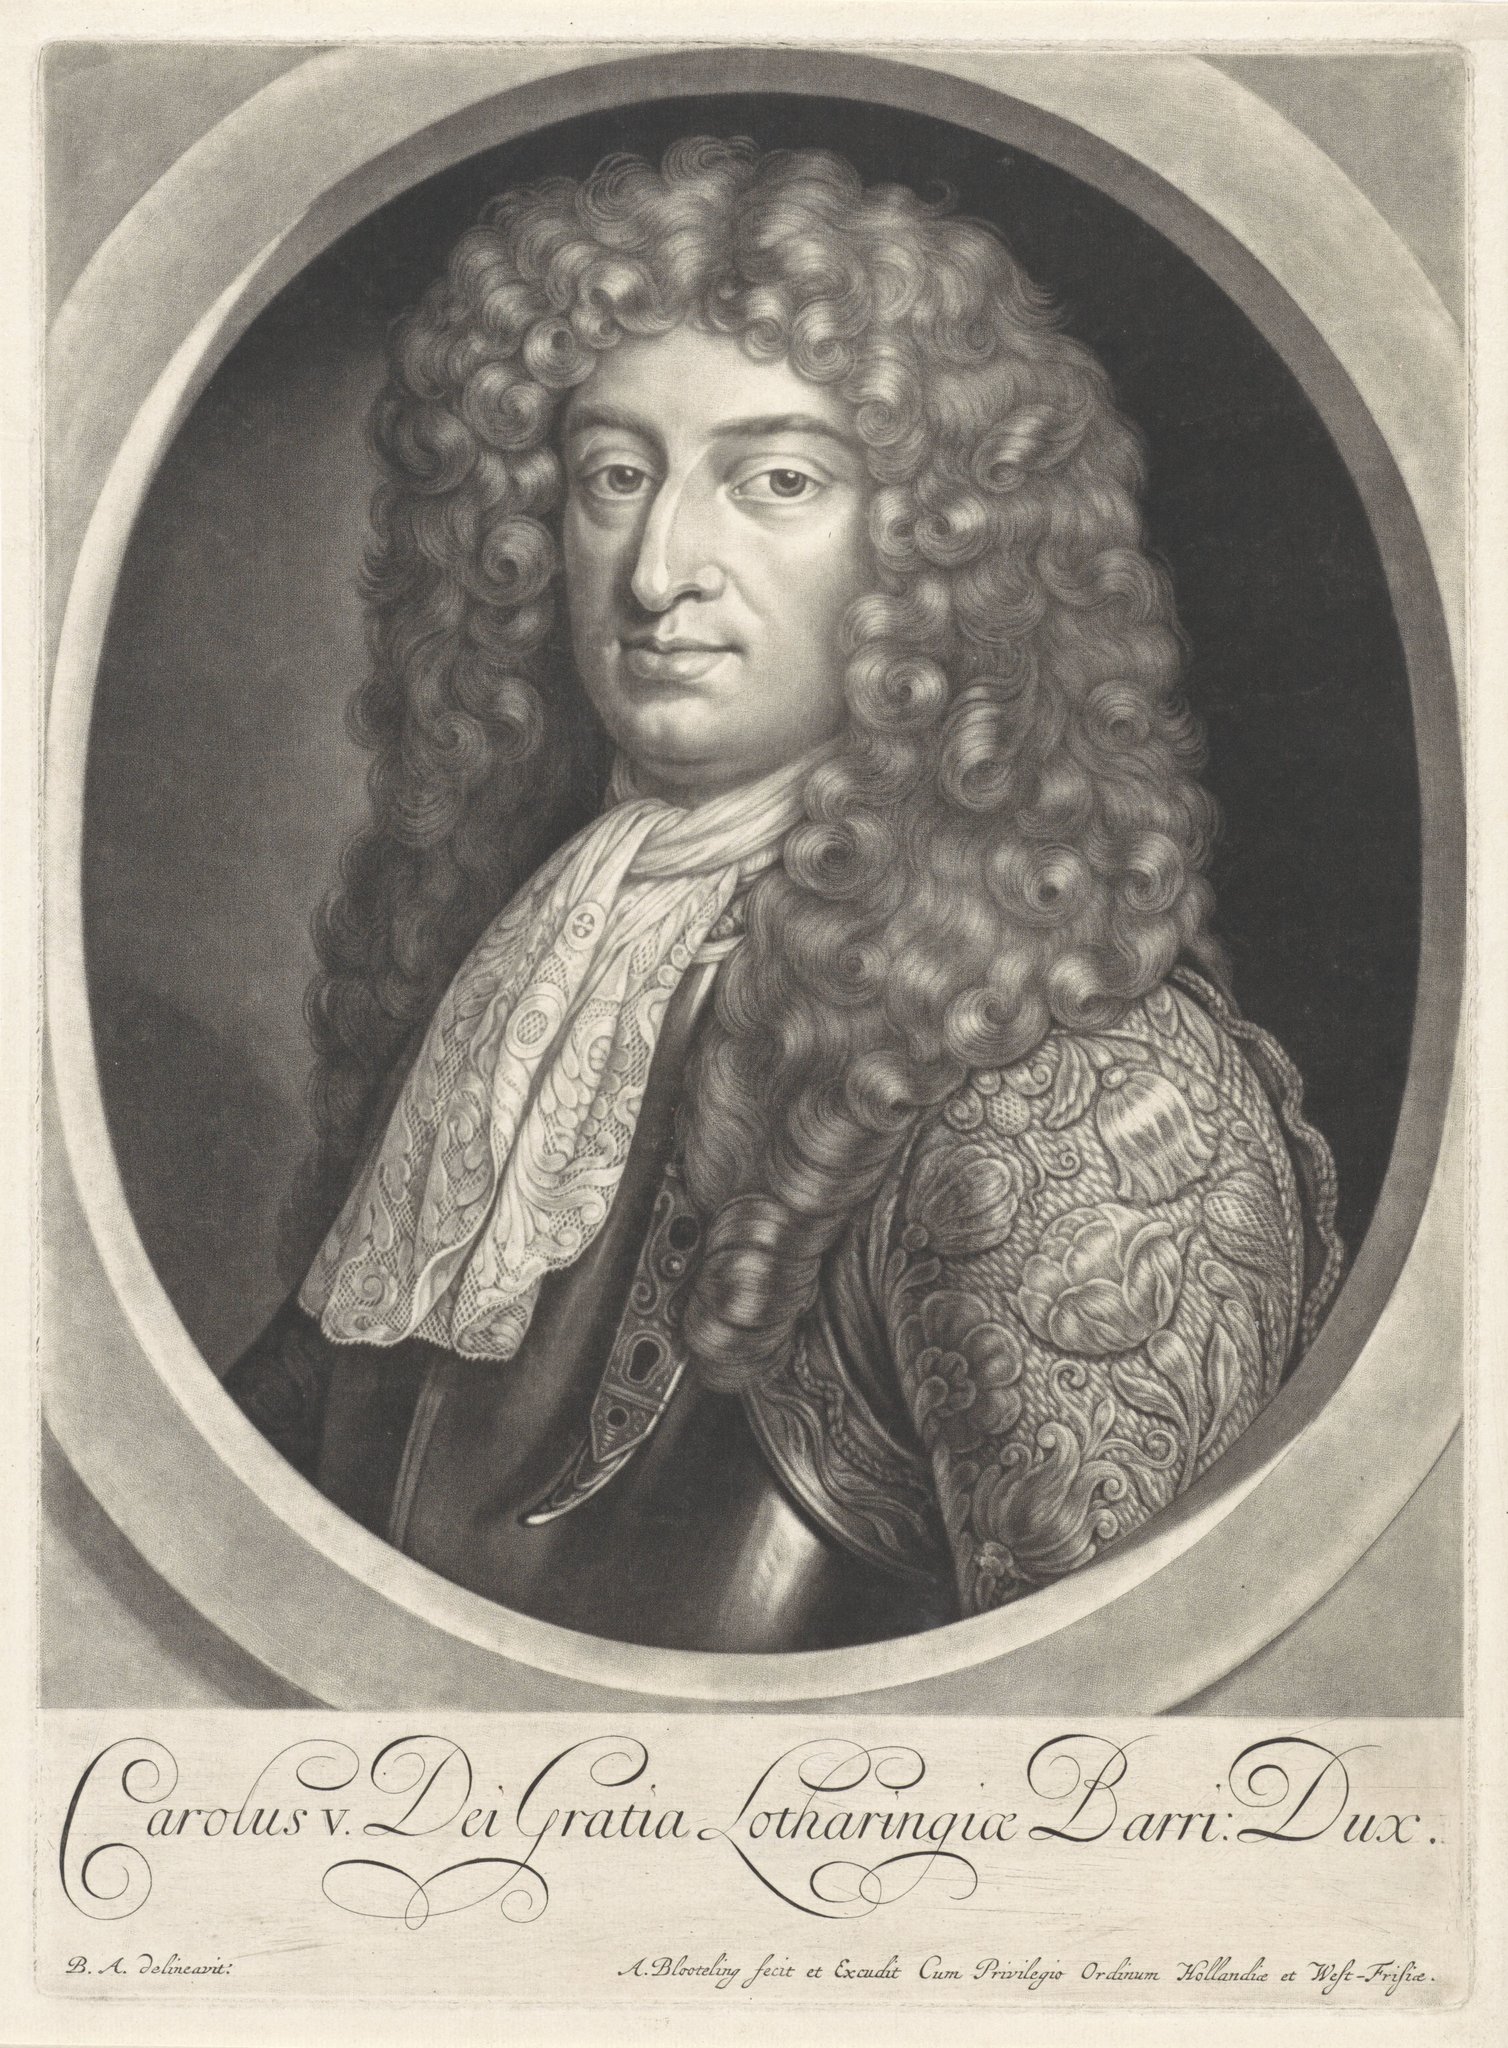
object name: print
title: Portret van Karel V Leopold, hertog van Lotharingen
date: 1675-1690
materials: paper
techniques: engraving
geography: amsterdam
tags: wels, karel v leopold (hertog van lotharingen)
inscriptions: collector's mark: Lugt 2228